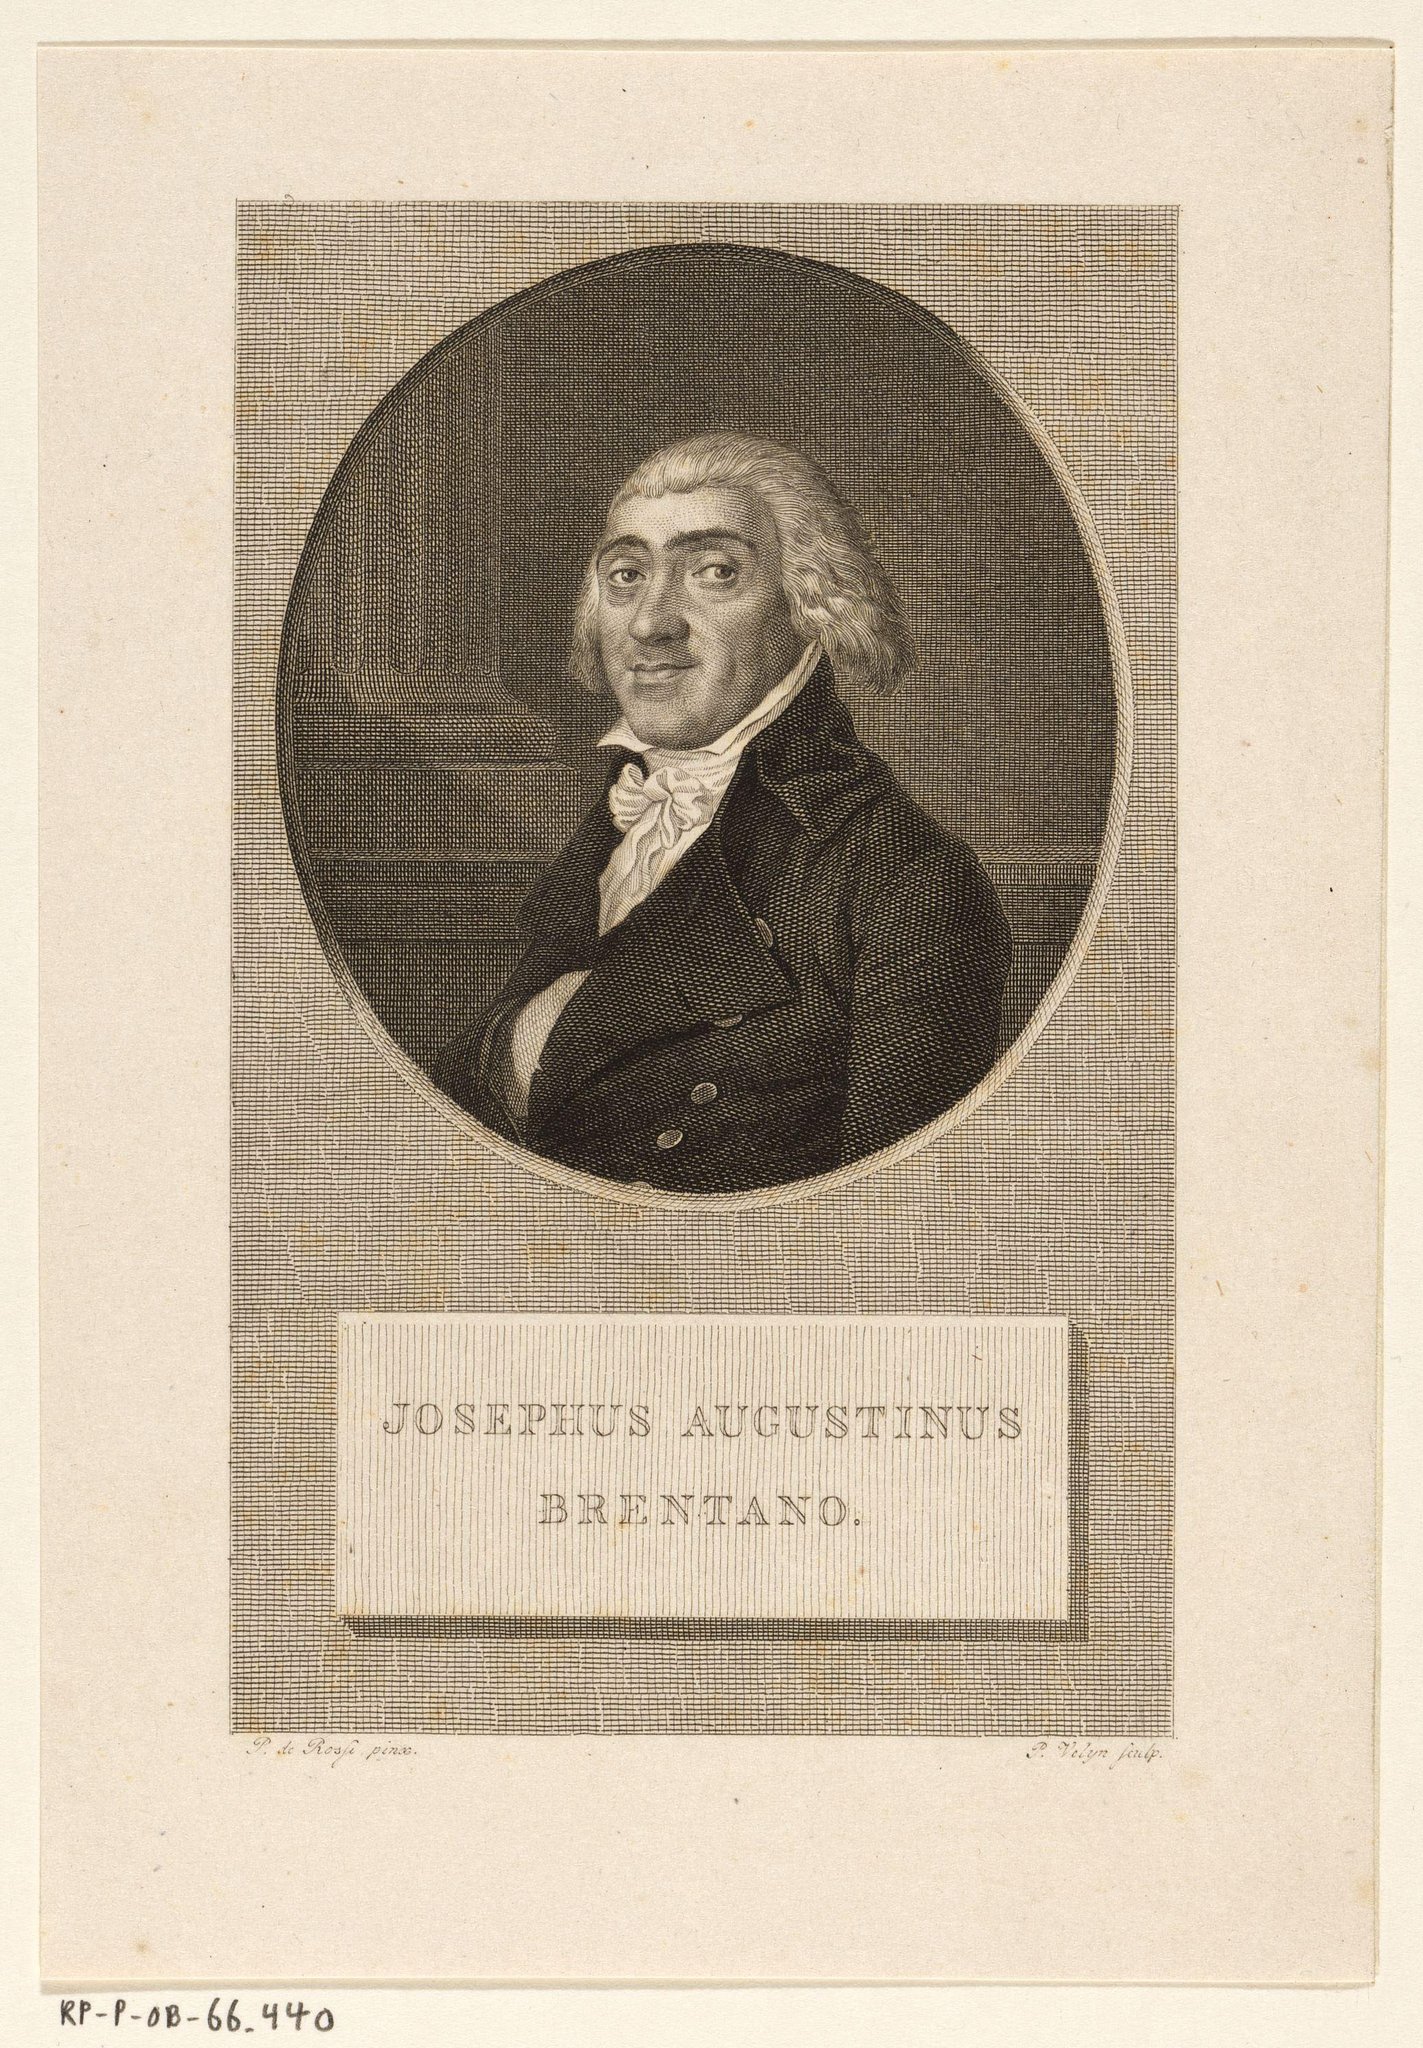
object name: print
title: Portret van Josephus Augustinus Brentano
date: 1797-1836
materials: paper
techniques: engraving, etching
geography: netherlands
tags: amsterdam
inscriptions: collector's mark: Lugt 2228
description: Portret van Josephus Augustinus Brentano, kunstverzamelaar te Amsterdam.